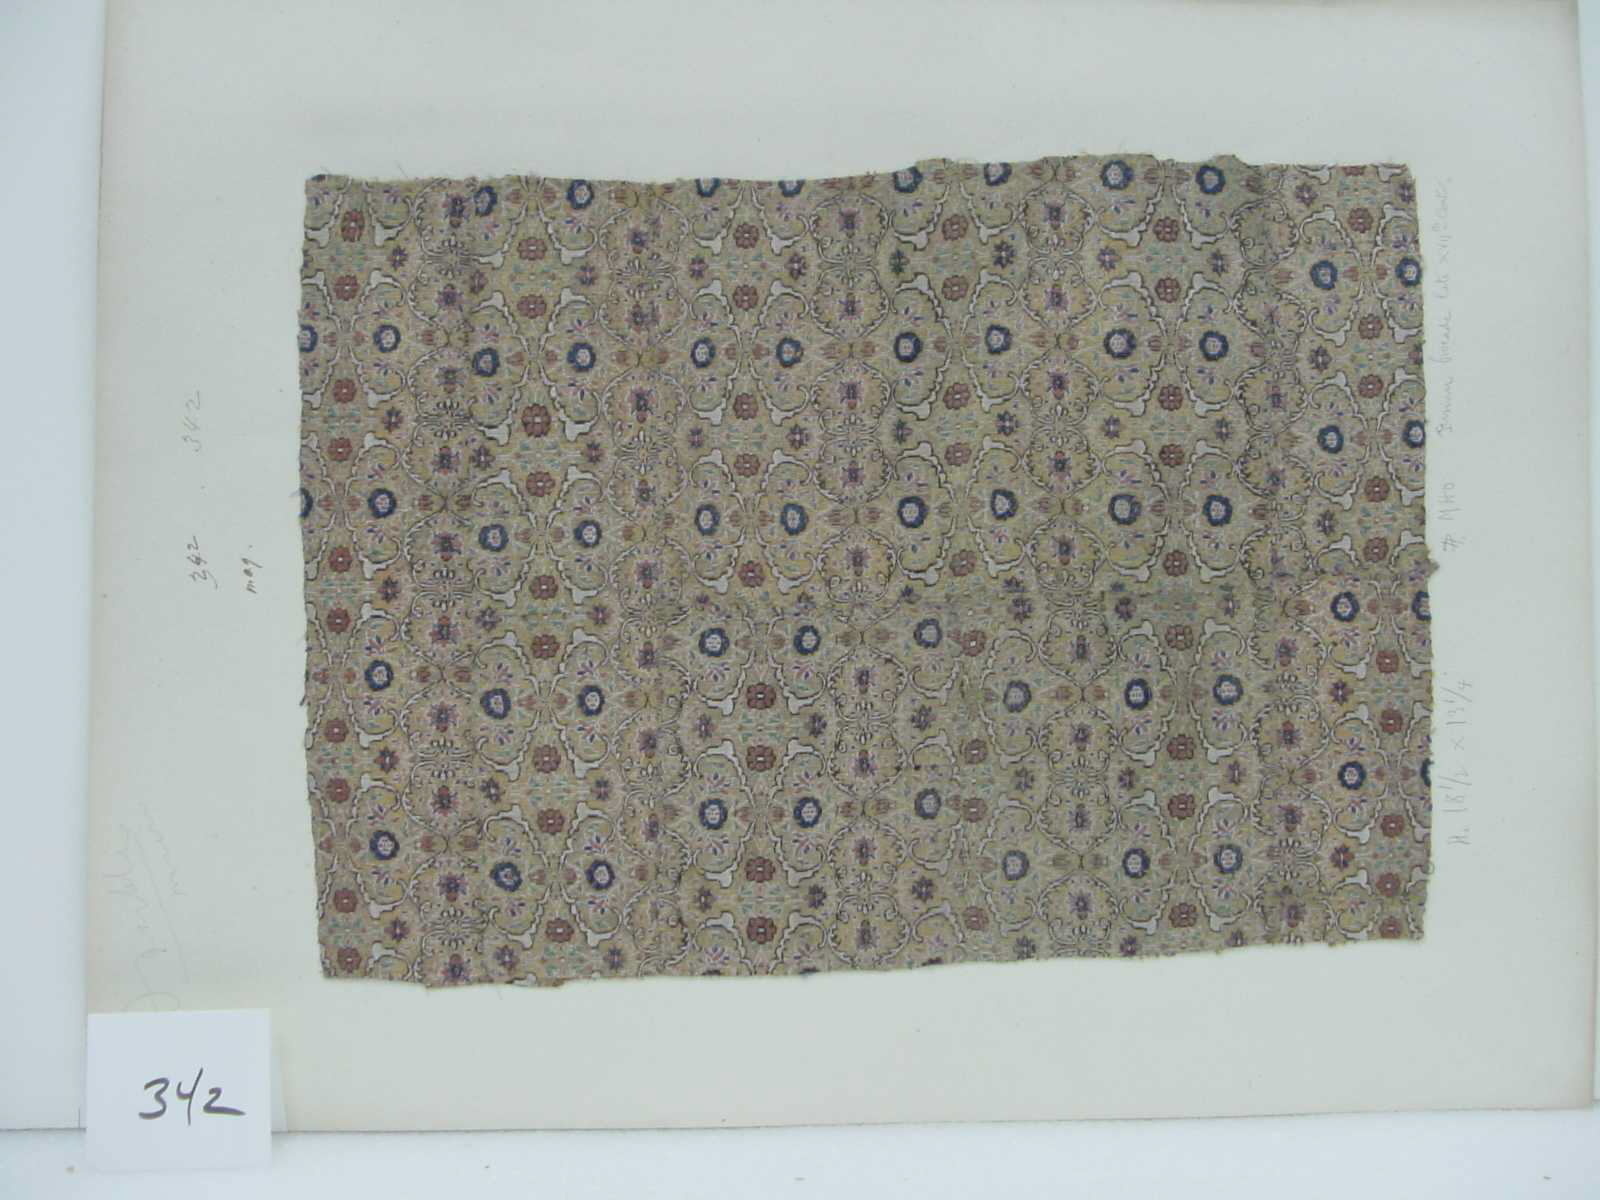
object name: textile fragment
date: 1667-1700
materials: silk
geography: iran